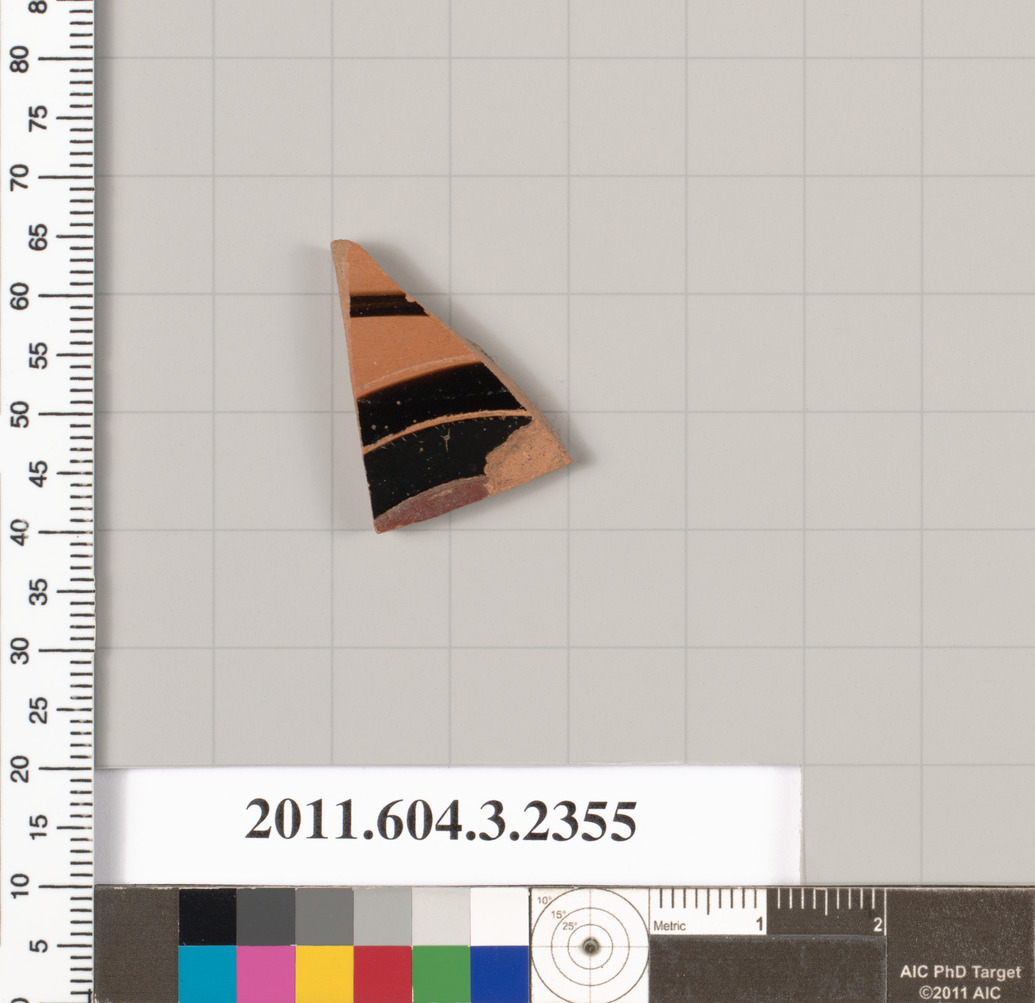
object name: kylix fragment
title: Terracotta fragment of a kylix: eye-cup (drinking cup)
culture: greek, attic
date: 540-510 BCE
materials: terracotta